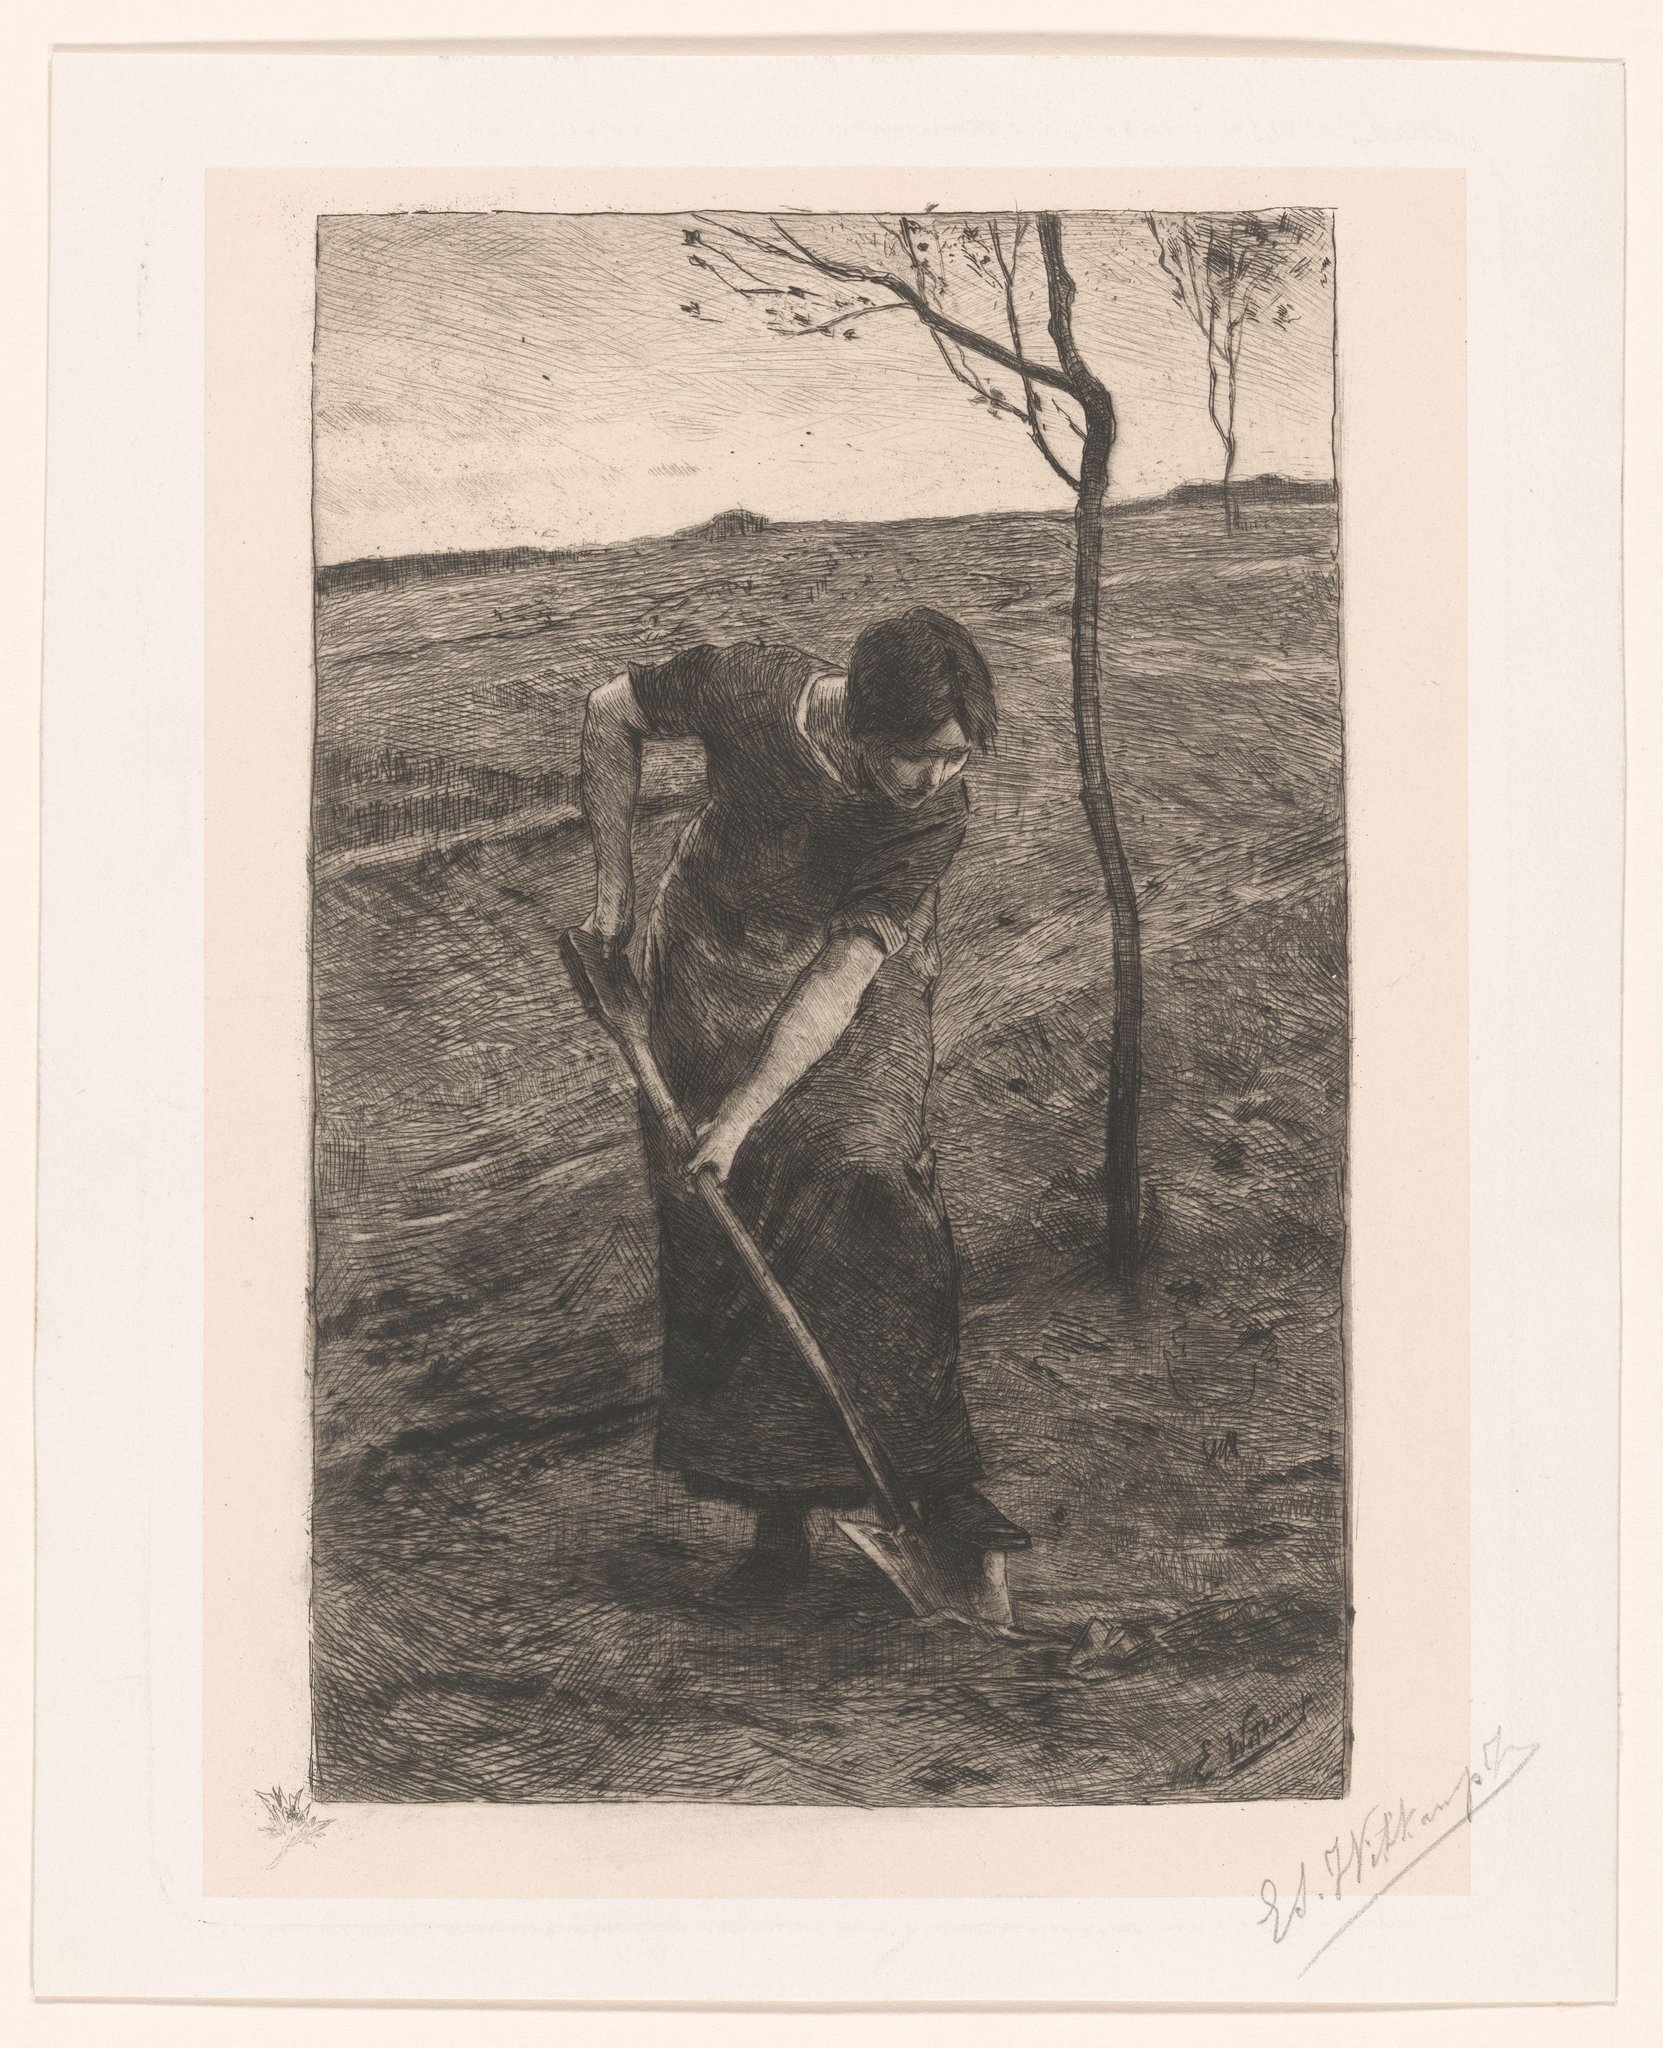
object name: print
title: Scheppende vrouw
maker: ernst witkamp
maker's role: draughtsman, print maker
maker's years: 1854-1897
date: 1864-1897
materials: paper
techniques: drypoint, etching, intaglio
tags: landscapes in the temperate zone, farmers, agricultural implements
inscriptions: collector's mark: Lugt 2228